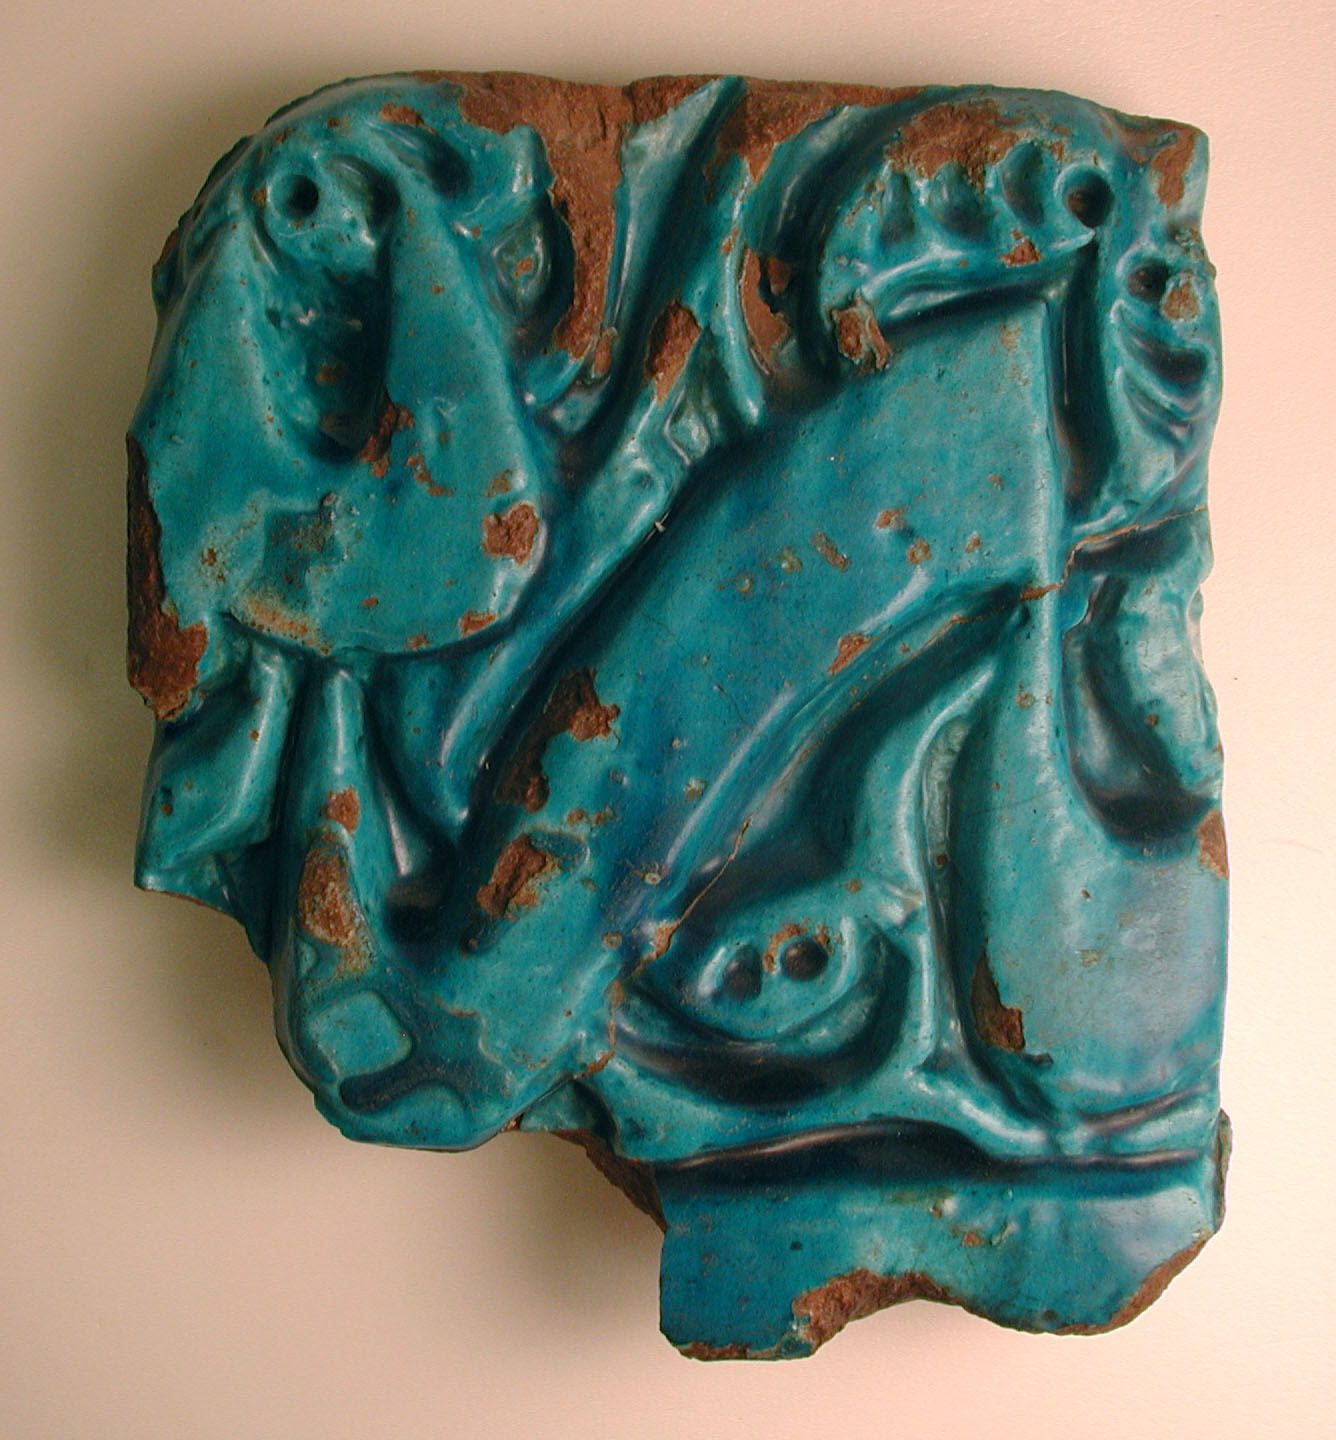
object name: tile fragment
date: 1101-1300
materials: glaze, stonepaste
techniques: carving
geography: iran